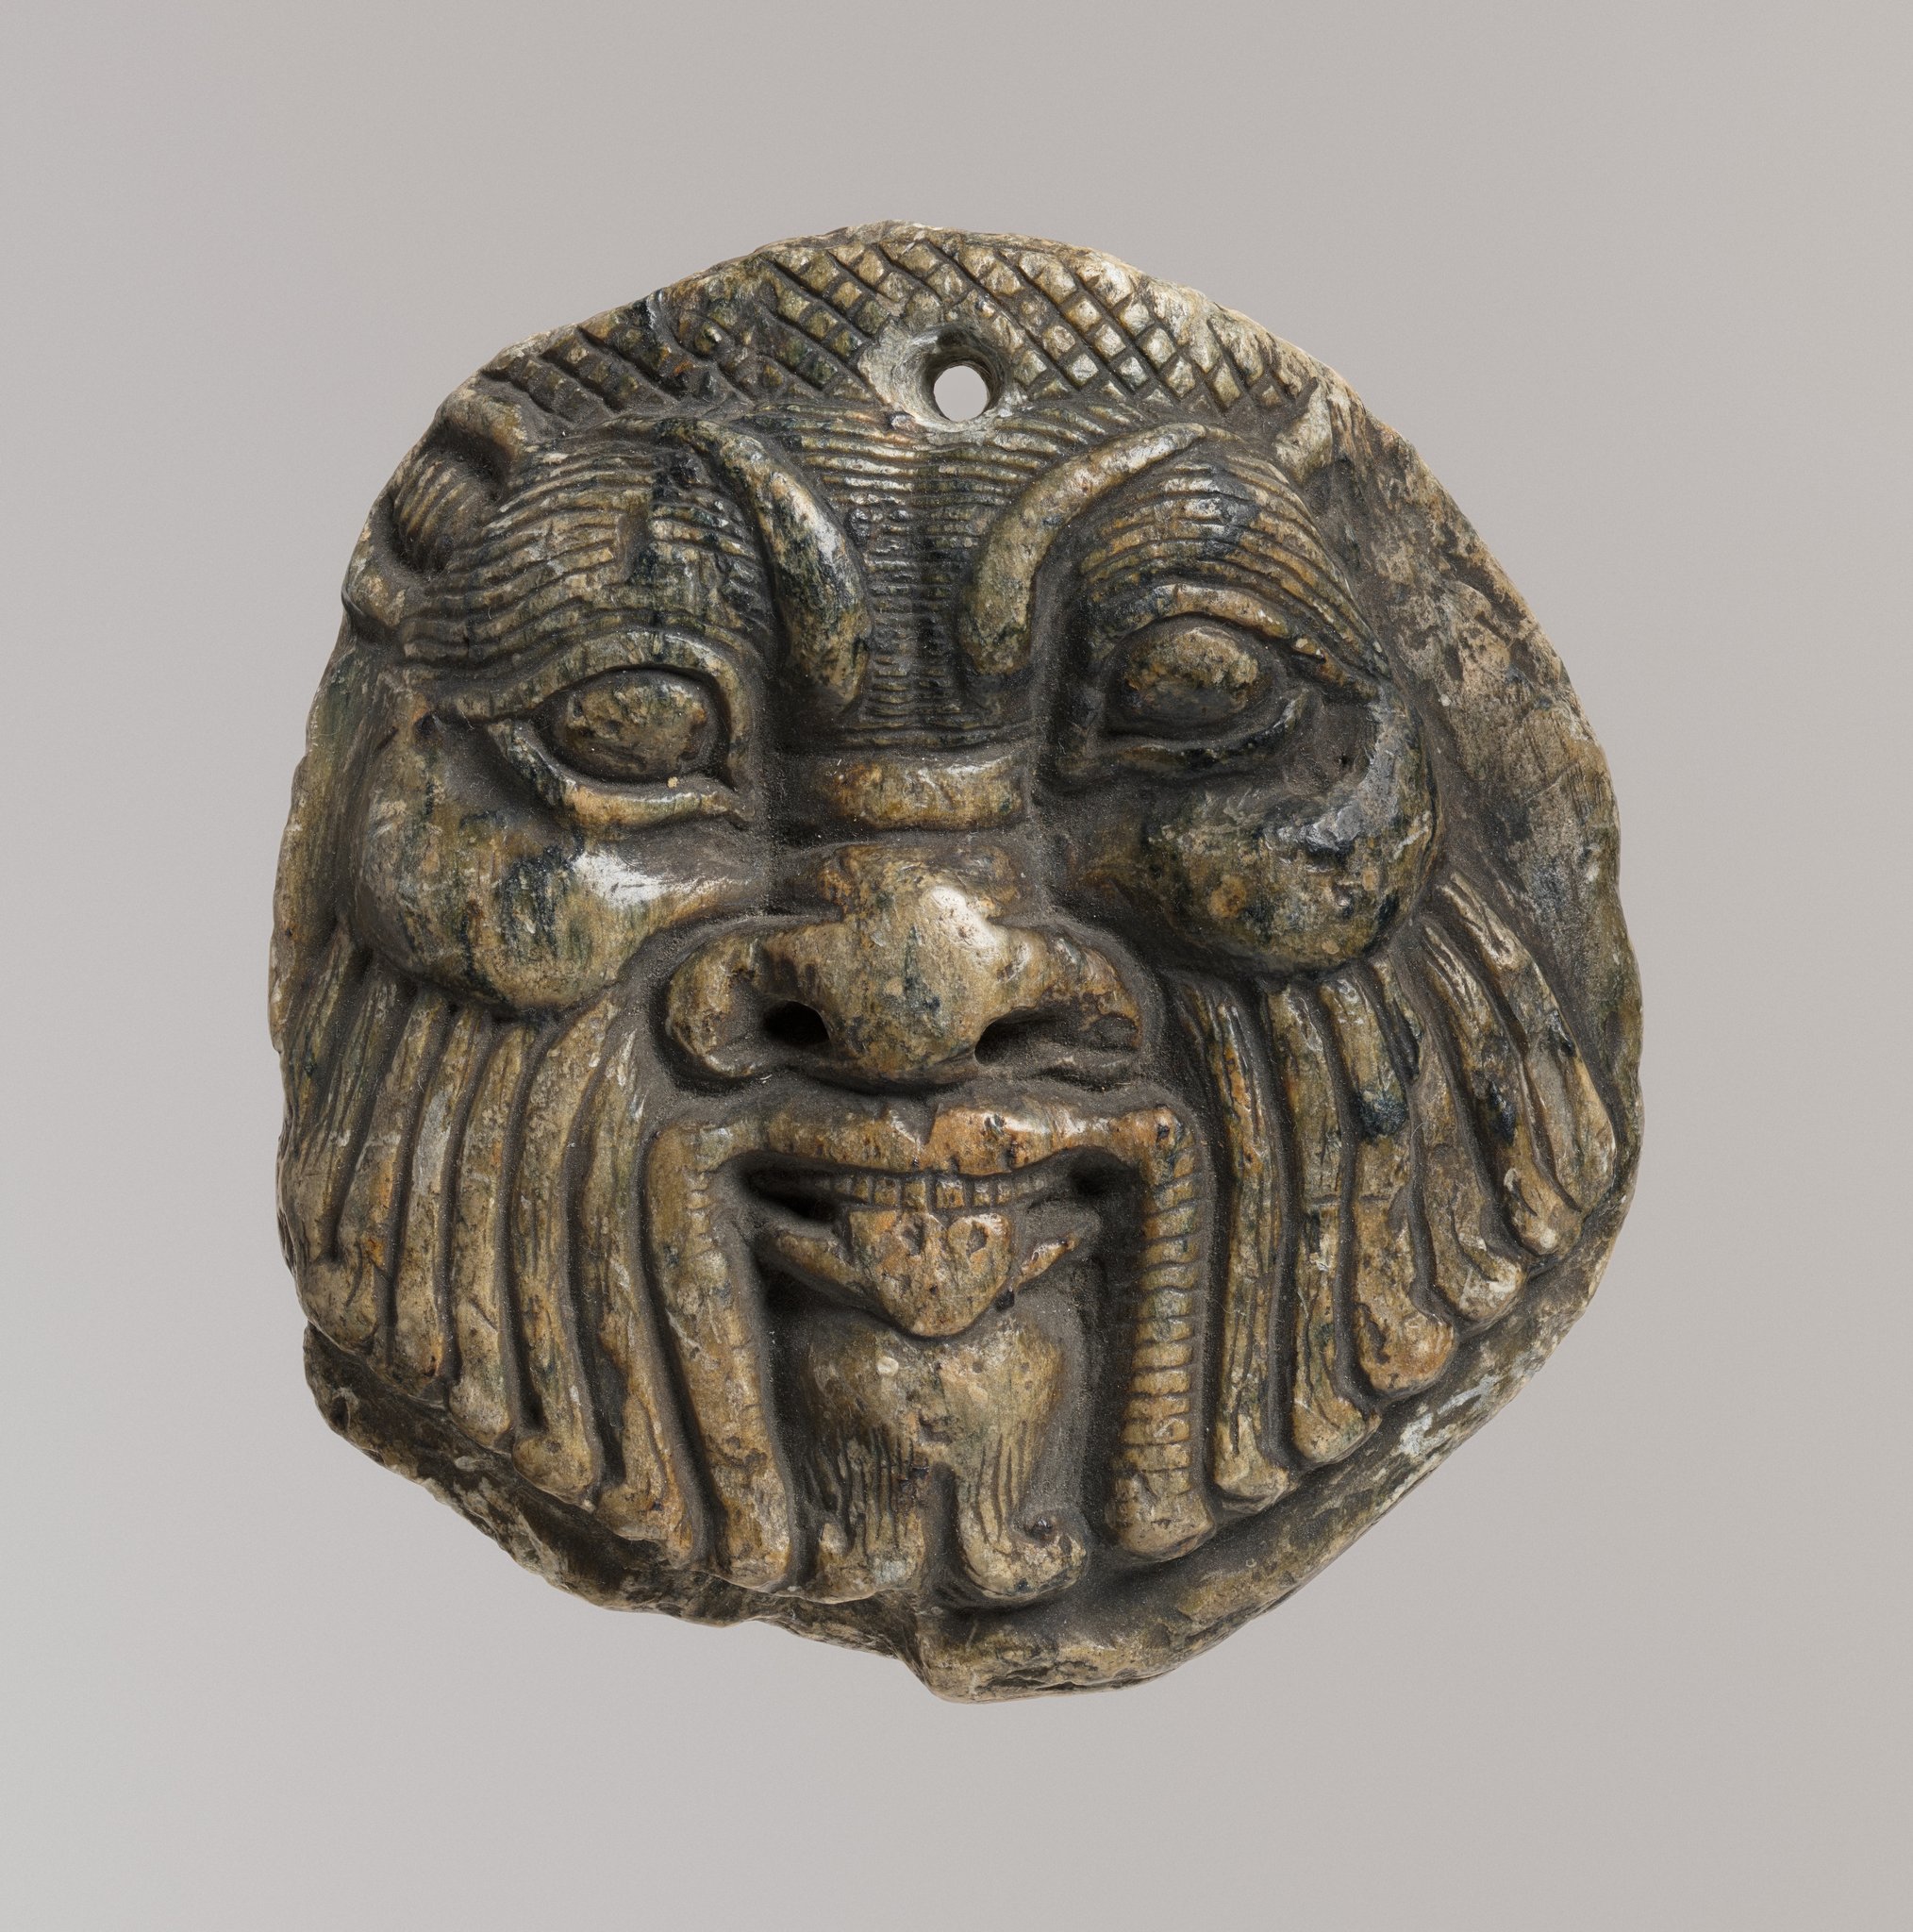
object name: amulet, be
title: Bes head disk with scene of Isis and Horus in marsh on reverse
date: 664-332 BCE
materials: stone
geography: egypt